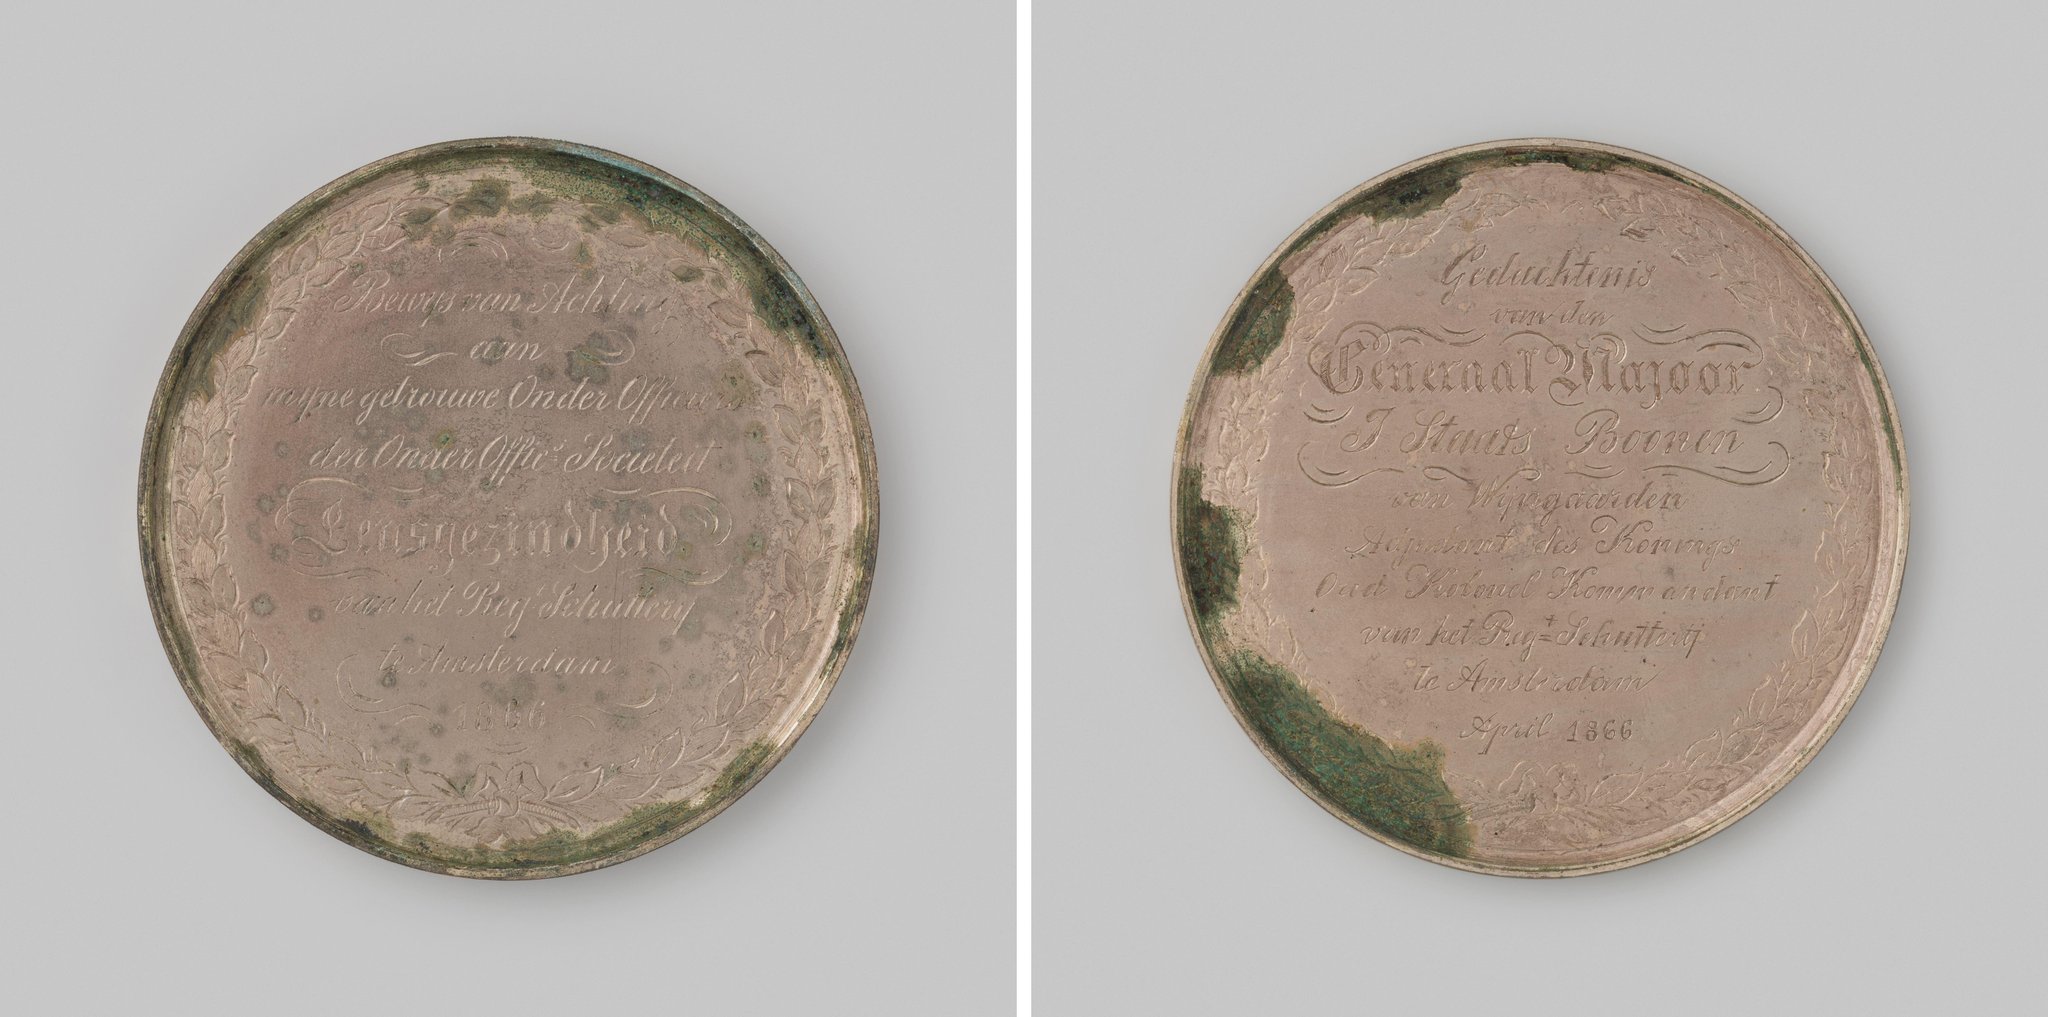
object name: history medal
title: Gedenkpenning door generaal-majoor J. Staats Boonen vereerd aan de Onderofficiers sociëteit Eensgezindheid van het regiment schutterij te Amsterdam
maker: Anonymous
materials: copper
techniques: galvanization